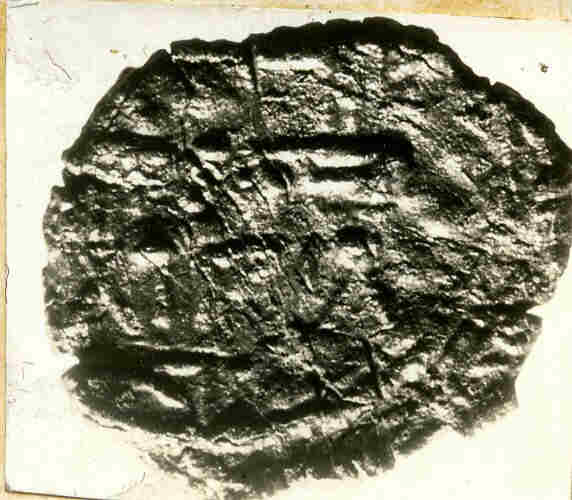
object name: coin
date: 815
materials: copper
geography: iran